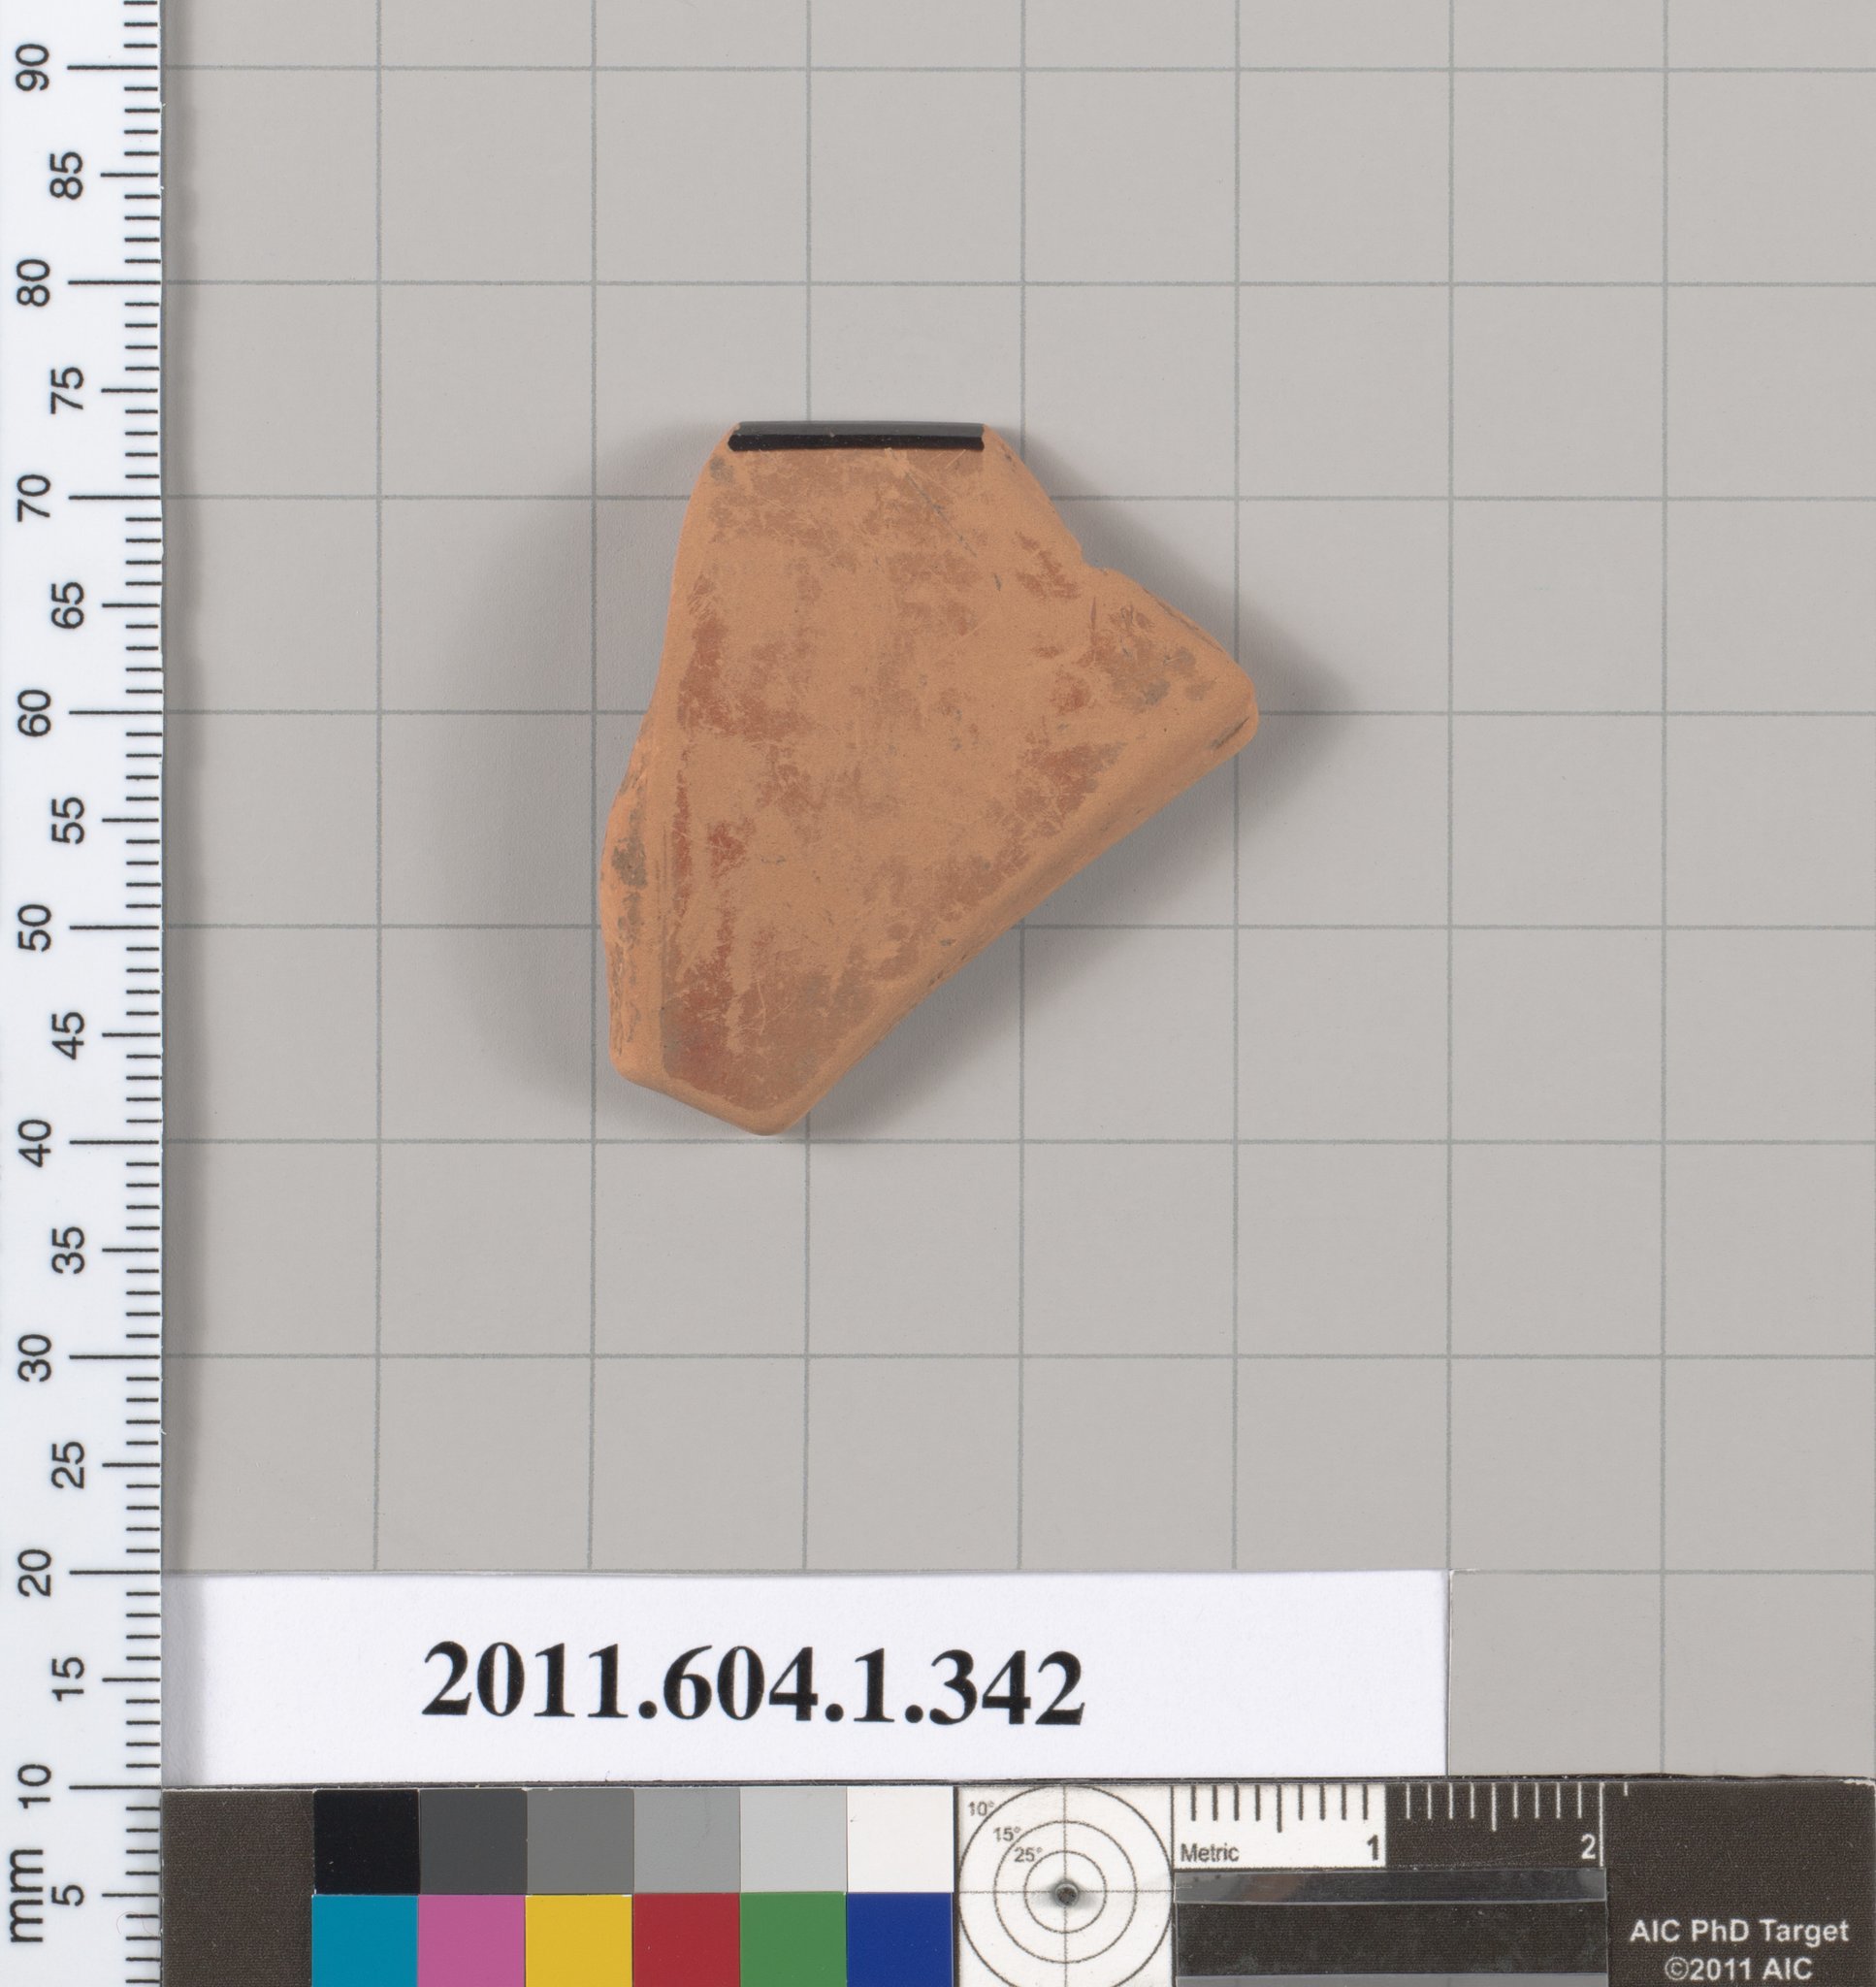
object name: kylix fragment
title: Terracotta rim fragment of a kylix (drinking cup)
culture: greek, attic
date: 475-451 BCE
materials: terracotta